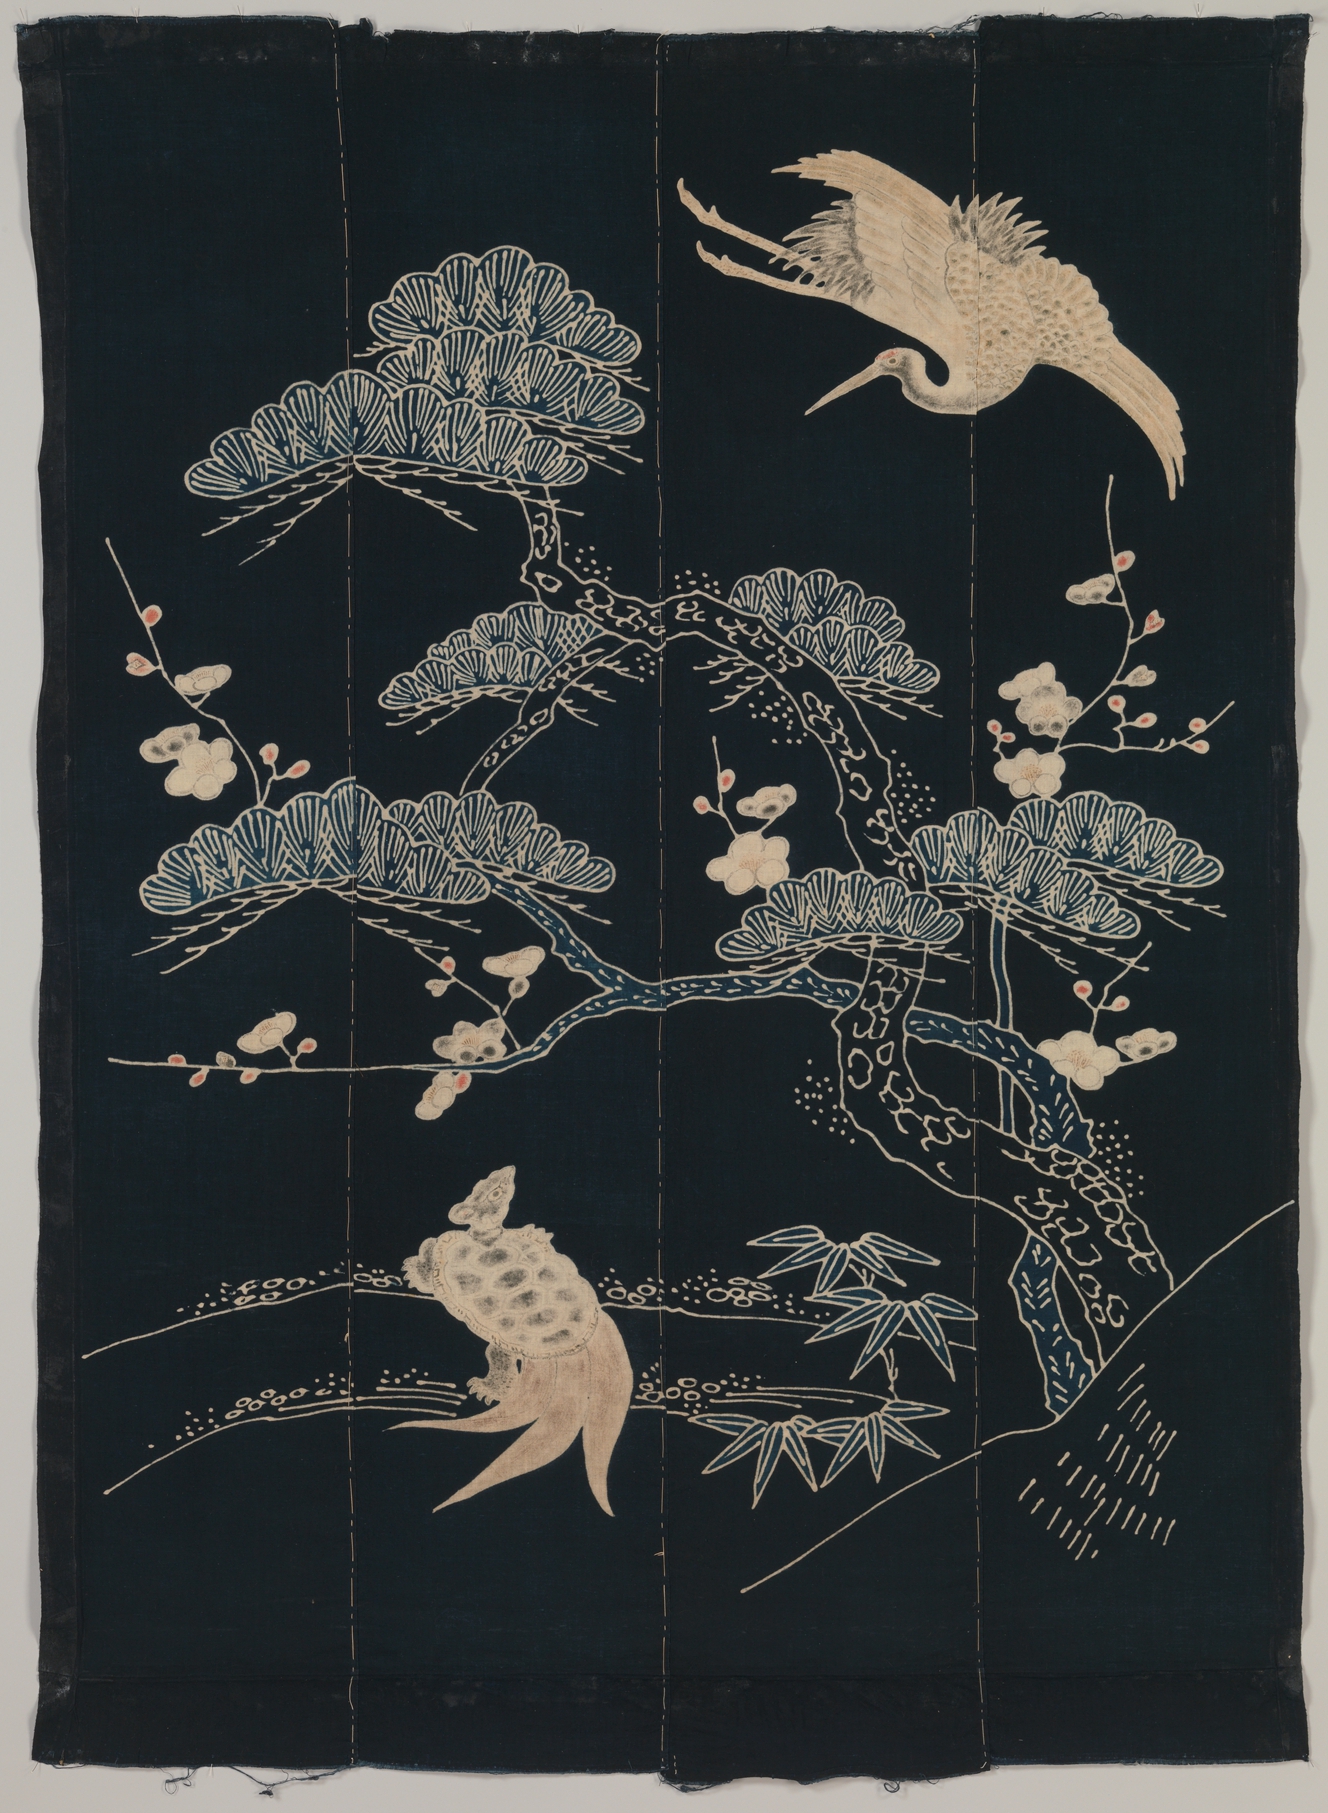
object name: futon cover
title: Futon Cover with Turtle, Crane, Pine, Plum, and Bamboo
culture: japanese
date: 1867-1933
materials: cotton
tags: cranes,fruit,turtles,trees